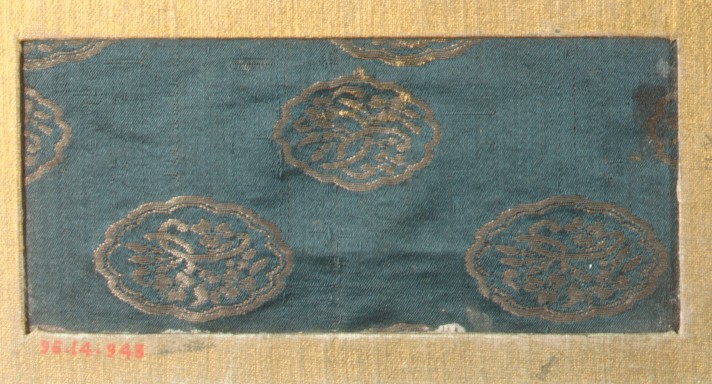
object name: piece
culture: japanese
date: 1701-1900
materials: silk